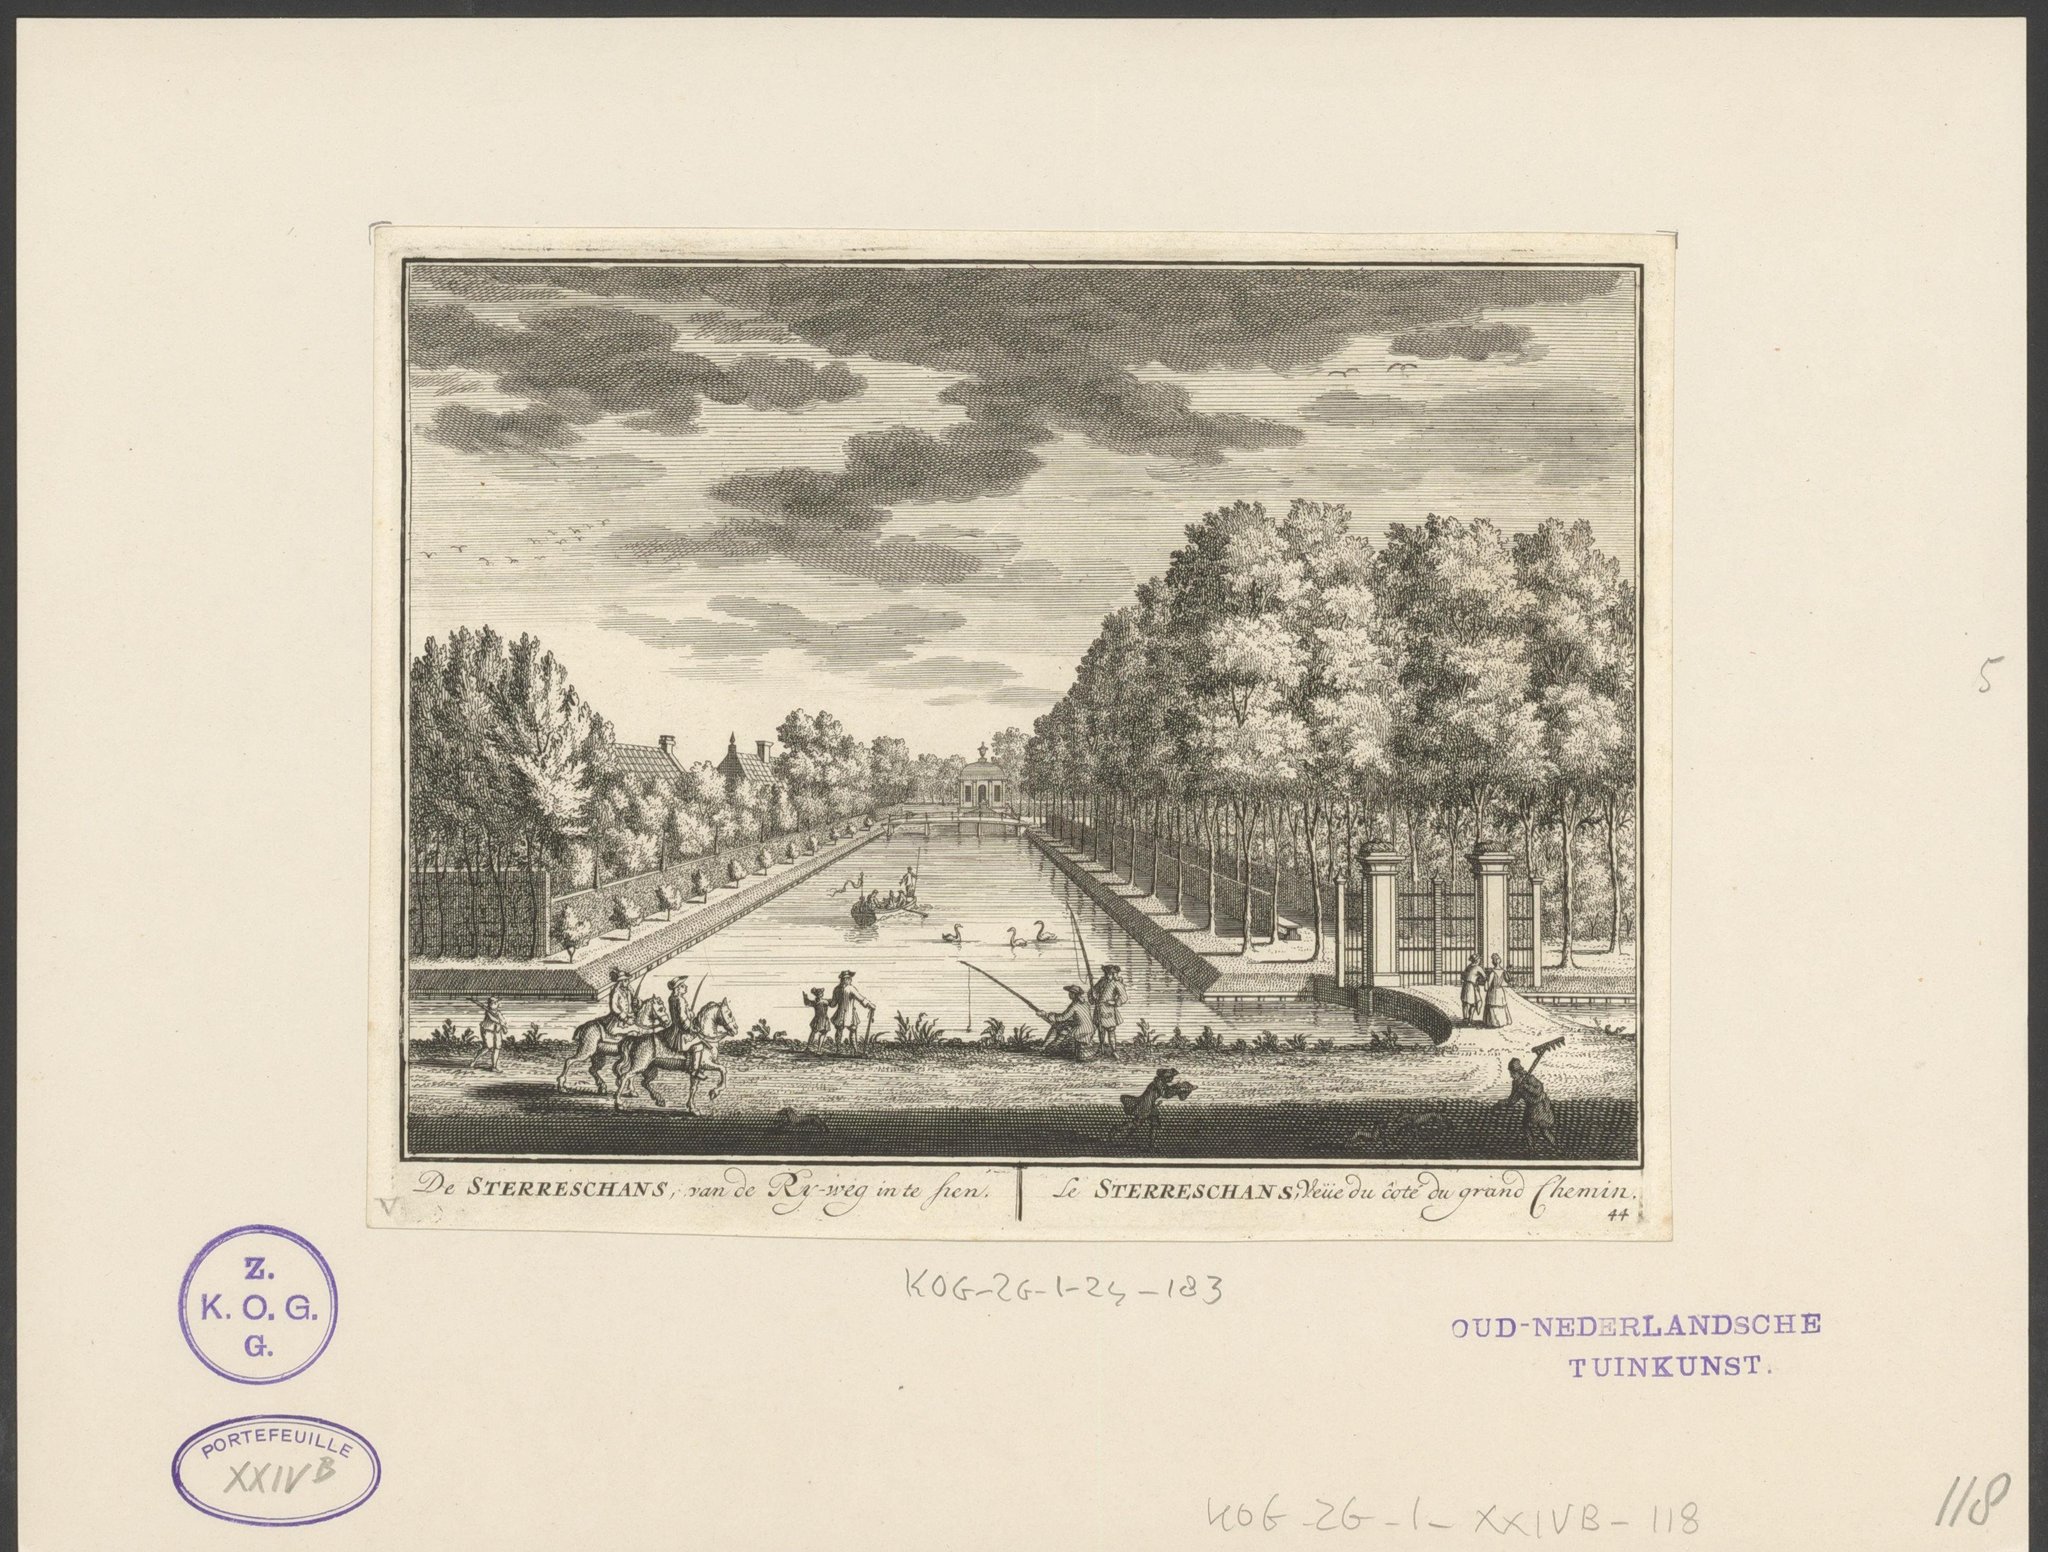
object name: print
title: Gezicht op buitenplaats Sterreschans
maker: hendrik de leth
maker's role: draughtsman, print maker, publisher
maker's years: 1703-1766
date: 1729-1732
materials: paper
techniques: engraving, etching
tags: french or architectonic garden; formal garden, country-house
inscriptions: stamp, stamp, collector's mark: Lugt 1641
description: Prent mogelijk uit: Brouërius van Nidek, Matthaeus. Het zegepralend Kennemerland, vertoond in 100 heerlyke gezichten. Amsterdam: Jan Roman, s.a. Of uit: Brouërius van Nidek, Matthaeus. Het zegepralend Kennemerland, vertoond in veele heerlyke gezichten. Amsterdam: Andries en Hendrik de Leth, s.a [1729-1732]. Of uit: Brouërius van Nidek, Matthaeus. Het zegepralend Kennemerland, vertoond in veele heerlyke gezichten. Amsterdam: Jan Roman, s.a.